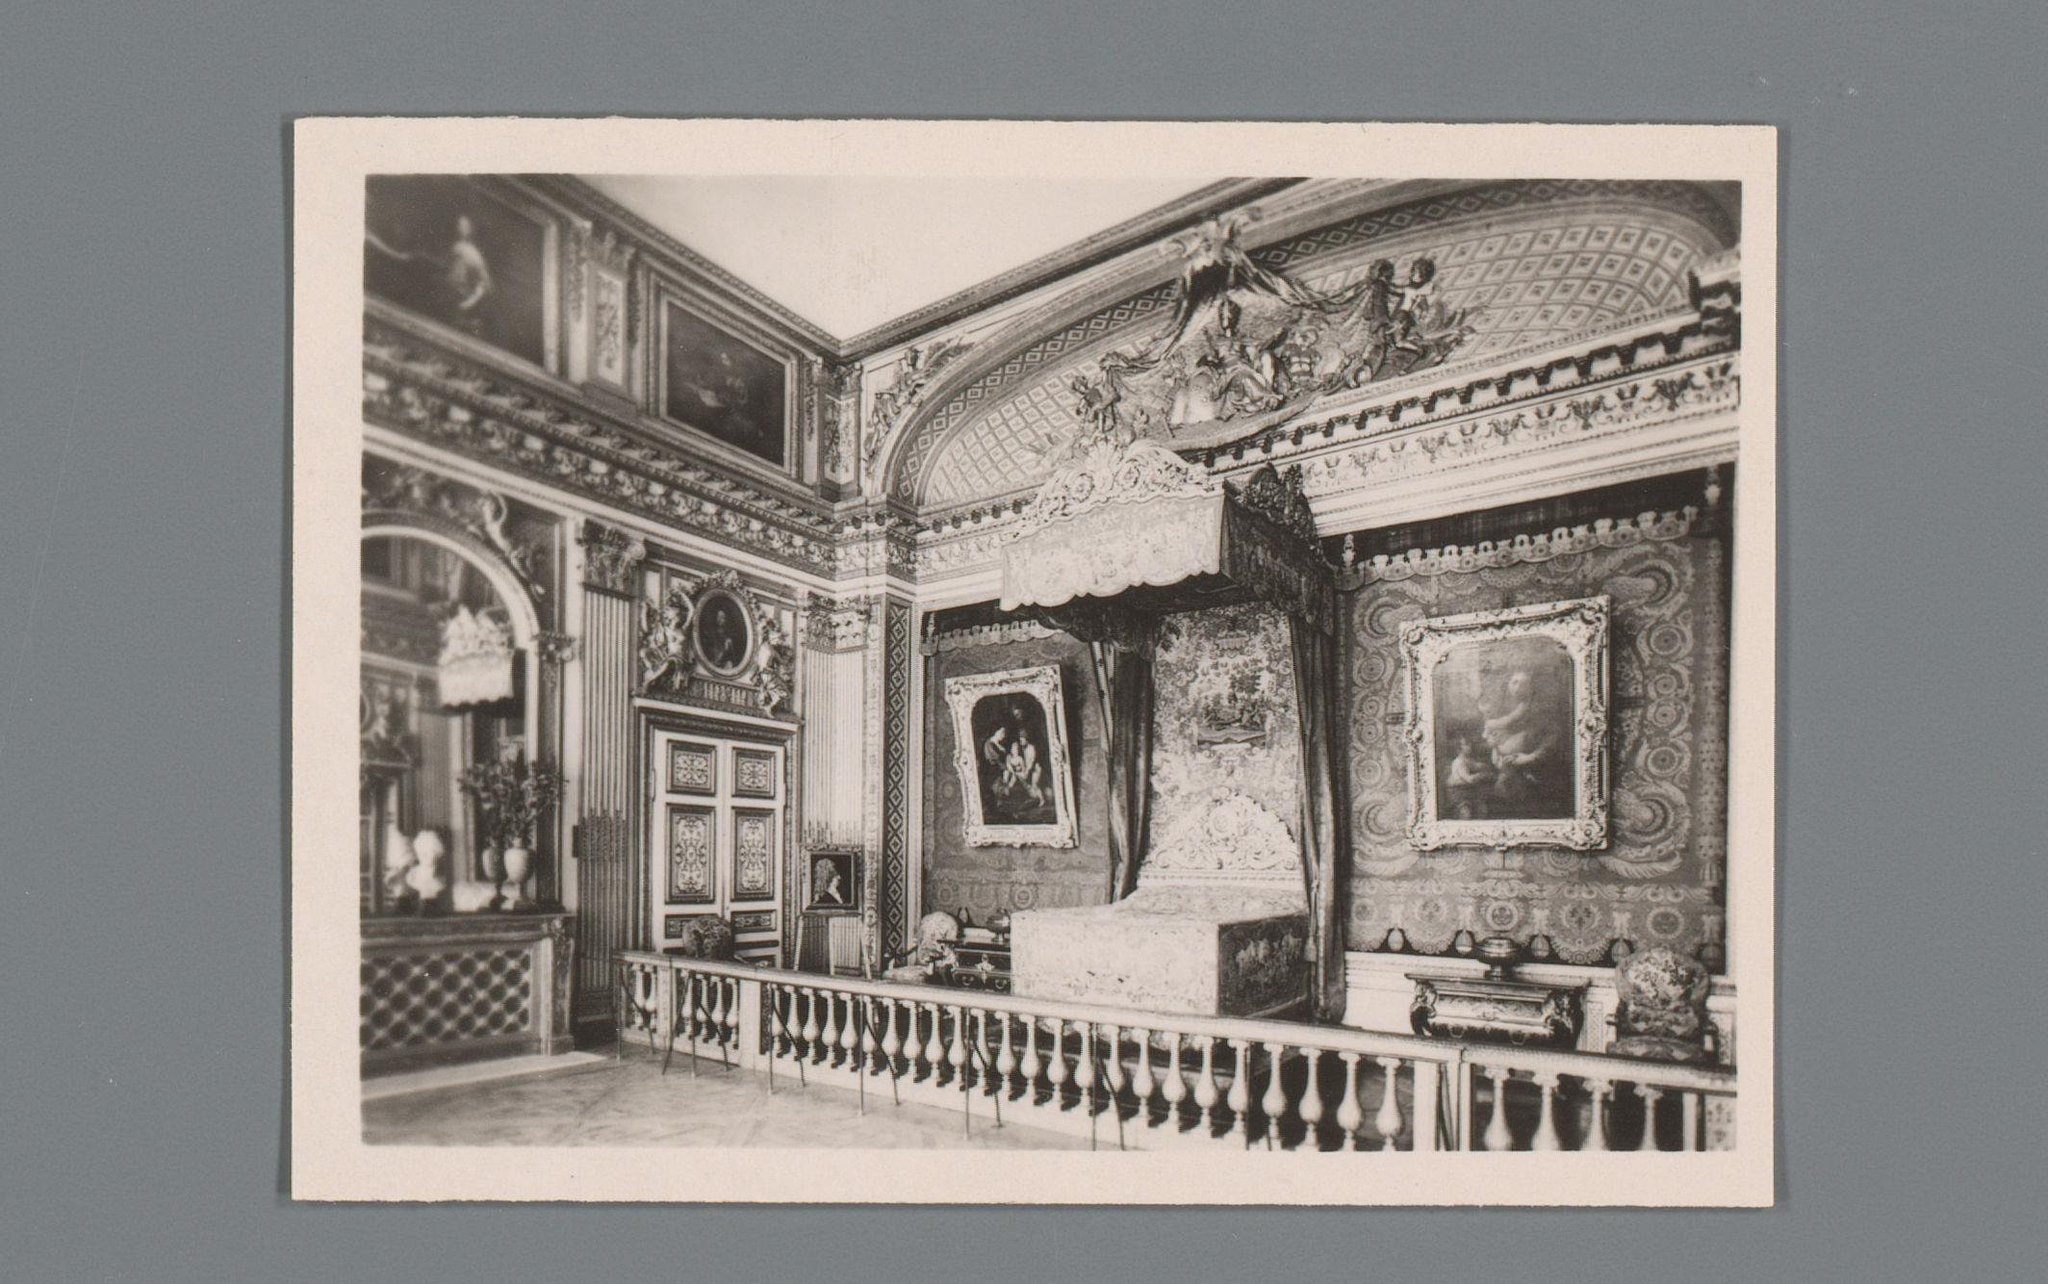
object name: photograph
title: Slaapkamer van Lodewijk XIV van Frankrijk in het kasteel van Versailles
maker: Anonymous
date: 1900-1920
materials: paper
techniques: gelatin silver print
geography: versailles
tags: palace - aa - civic architecture: inside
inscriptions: number: ‘8’